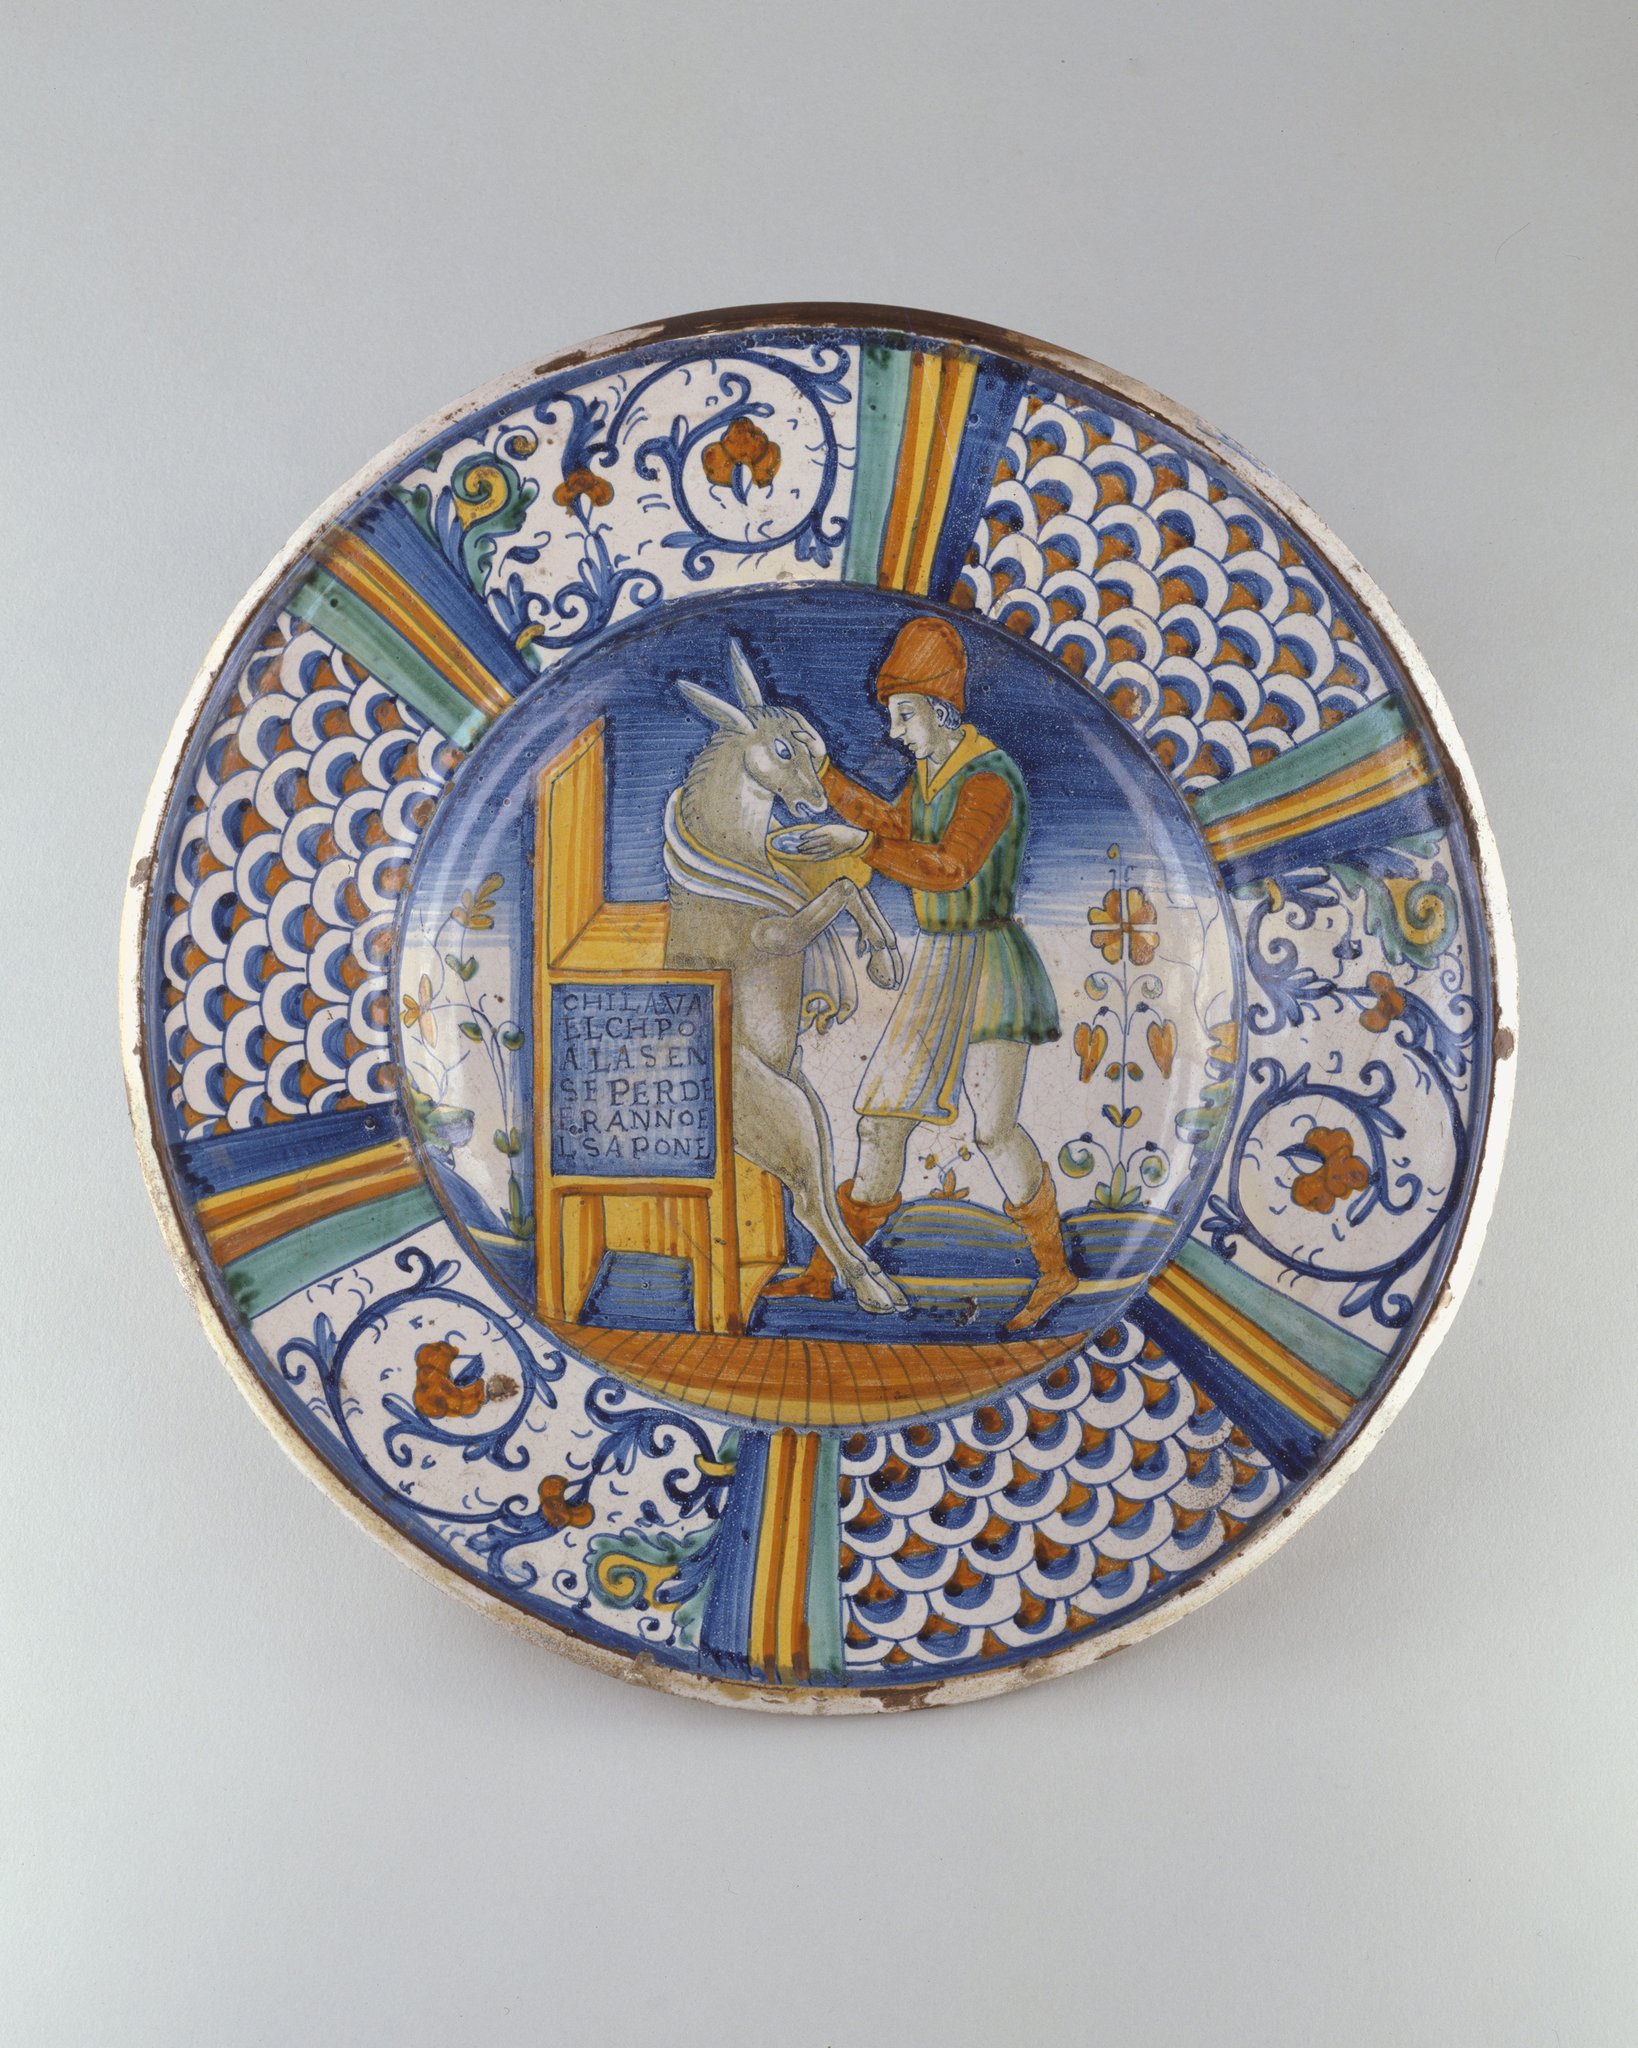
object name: dish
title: Dish (piatto): Man Washing the Mouth of an Ass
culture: italian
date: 1550-1560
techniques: maiolica, glazing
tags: men,donkeys